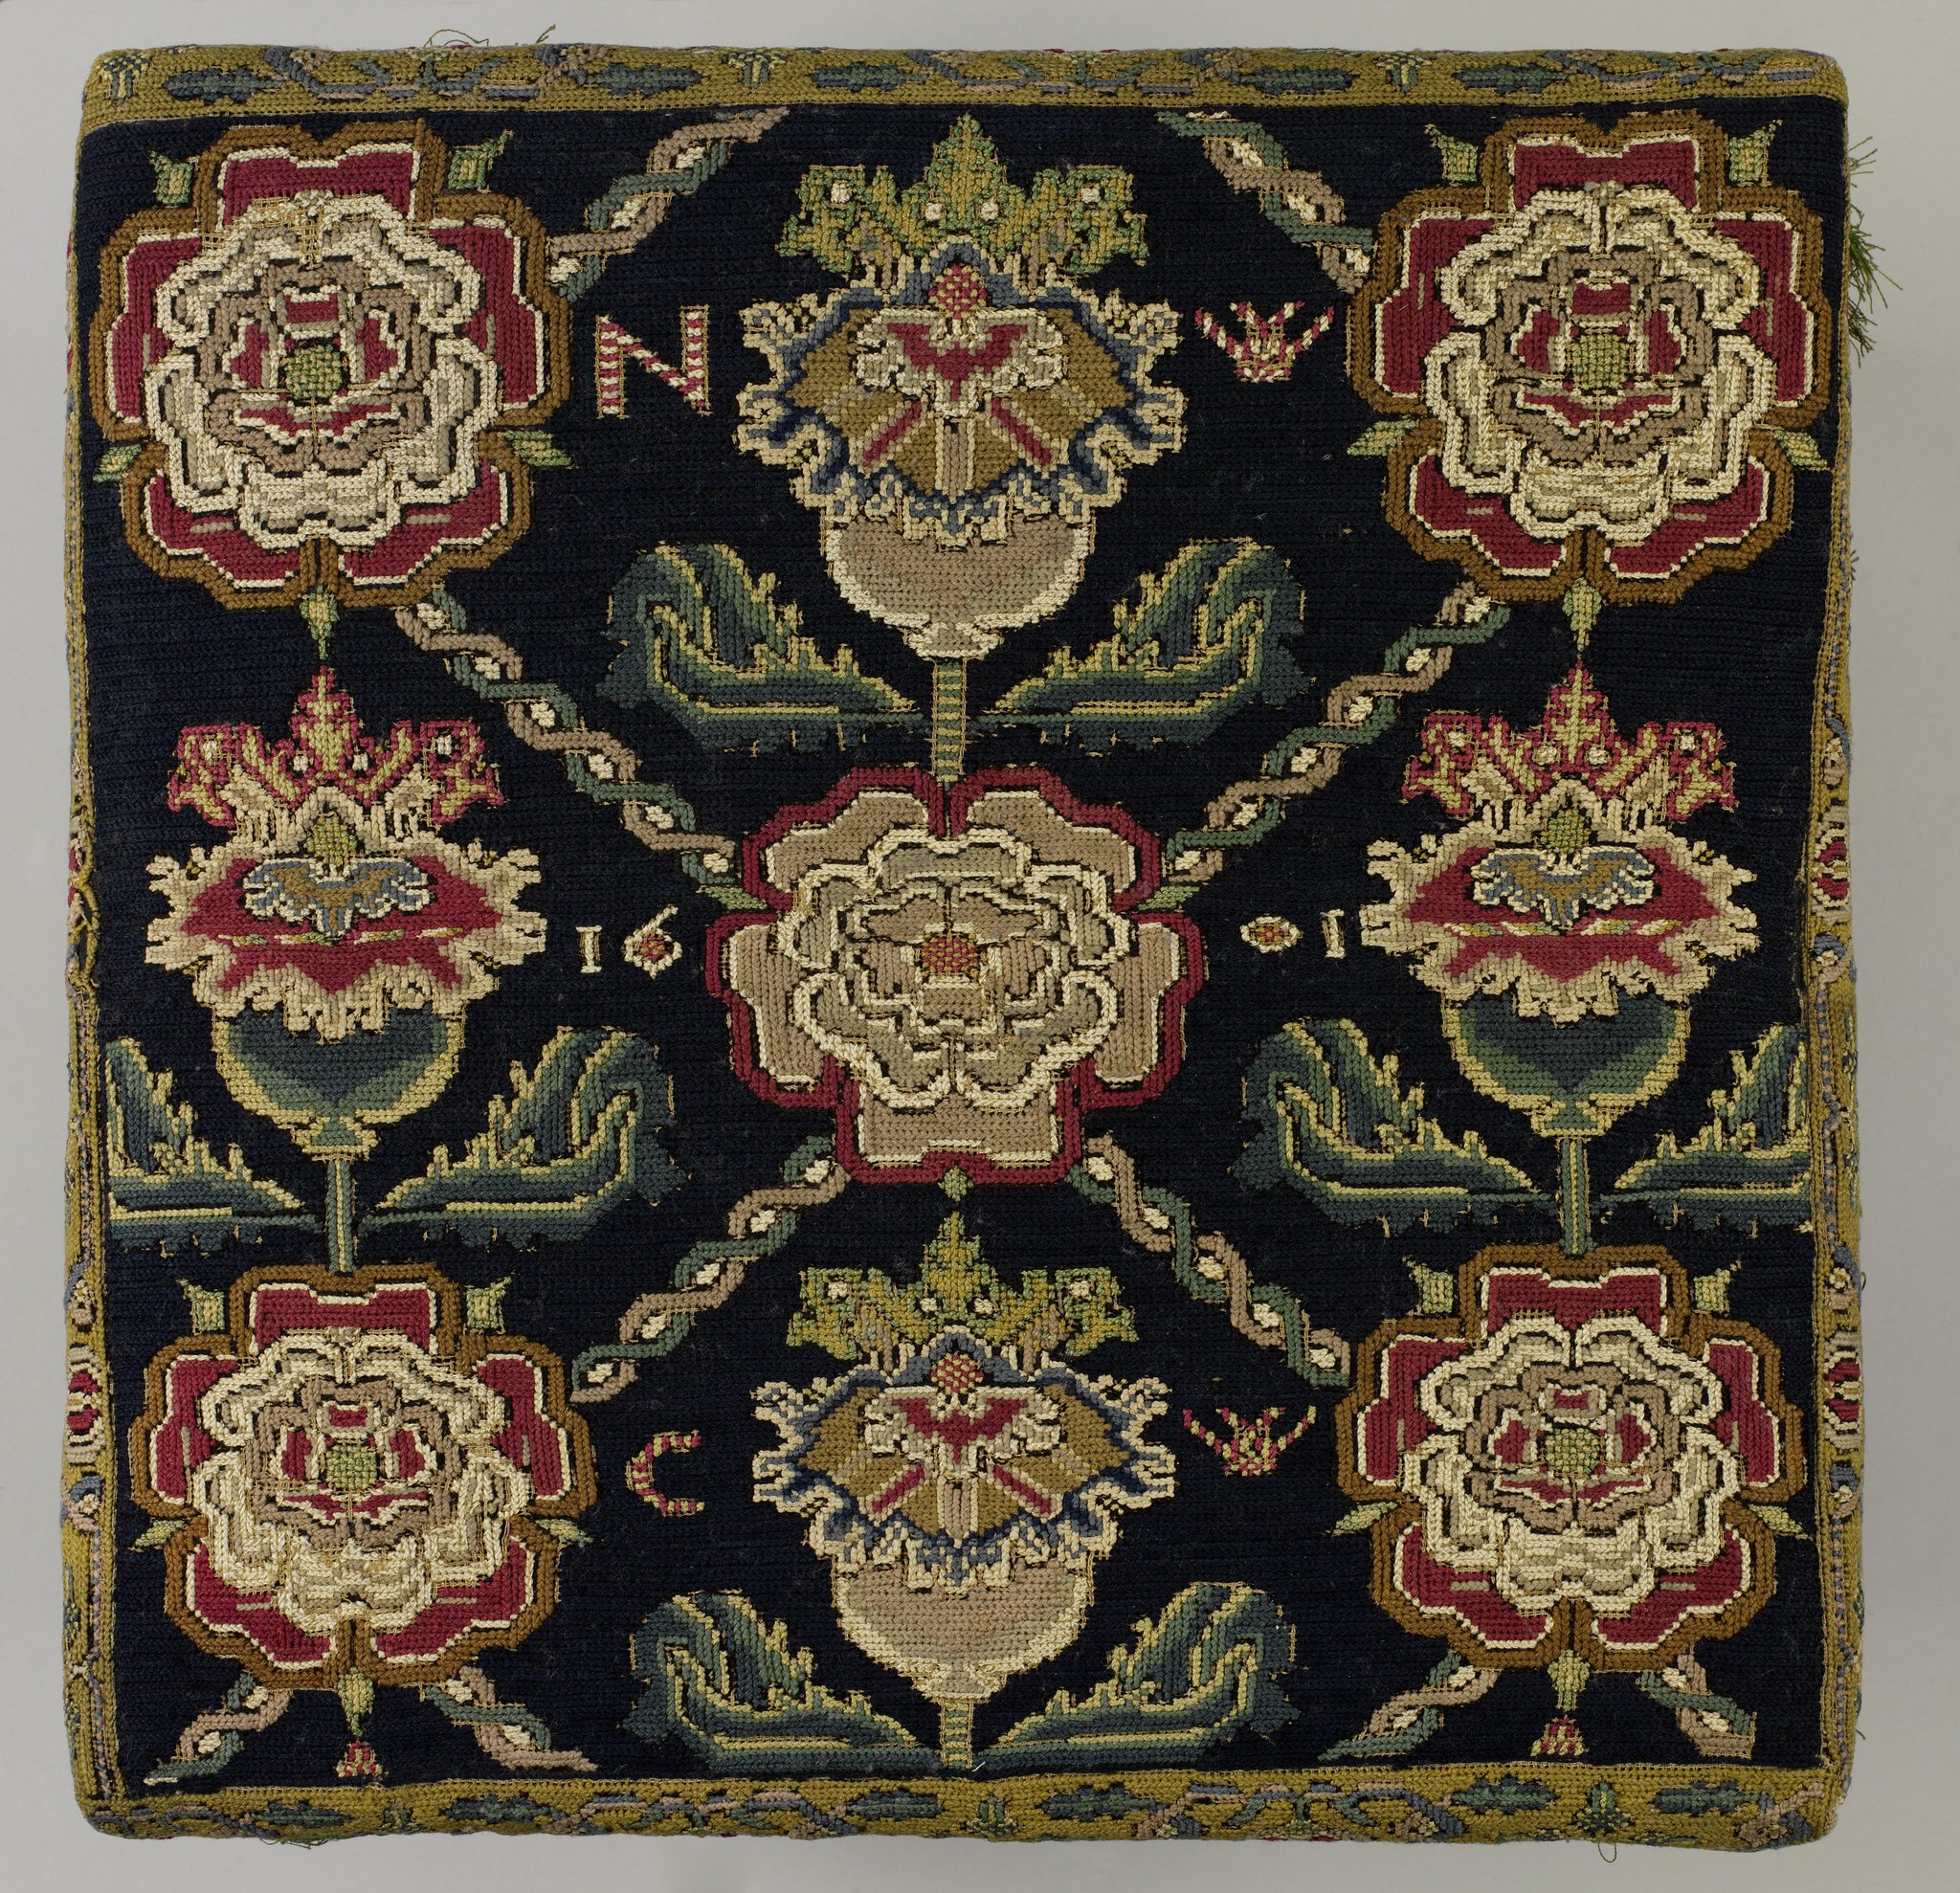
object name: cushion cover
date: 1601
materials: canvas, thread, wool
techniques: embroidery, stitching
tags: flowers